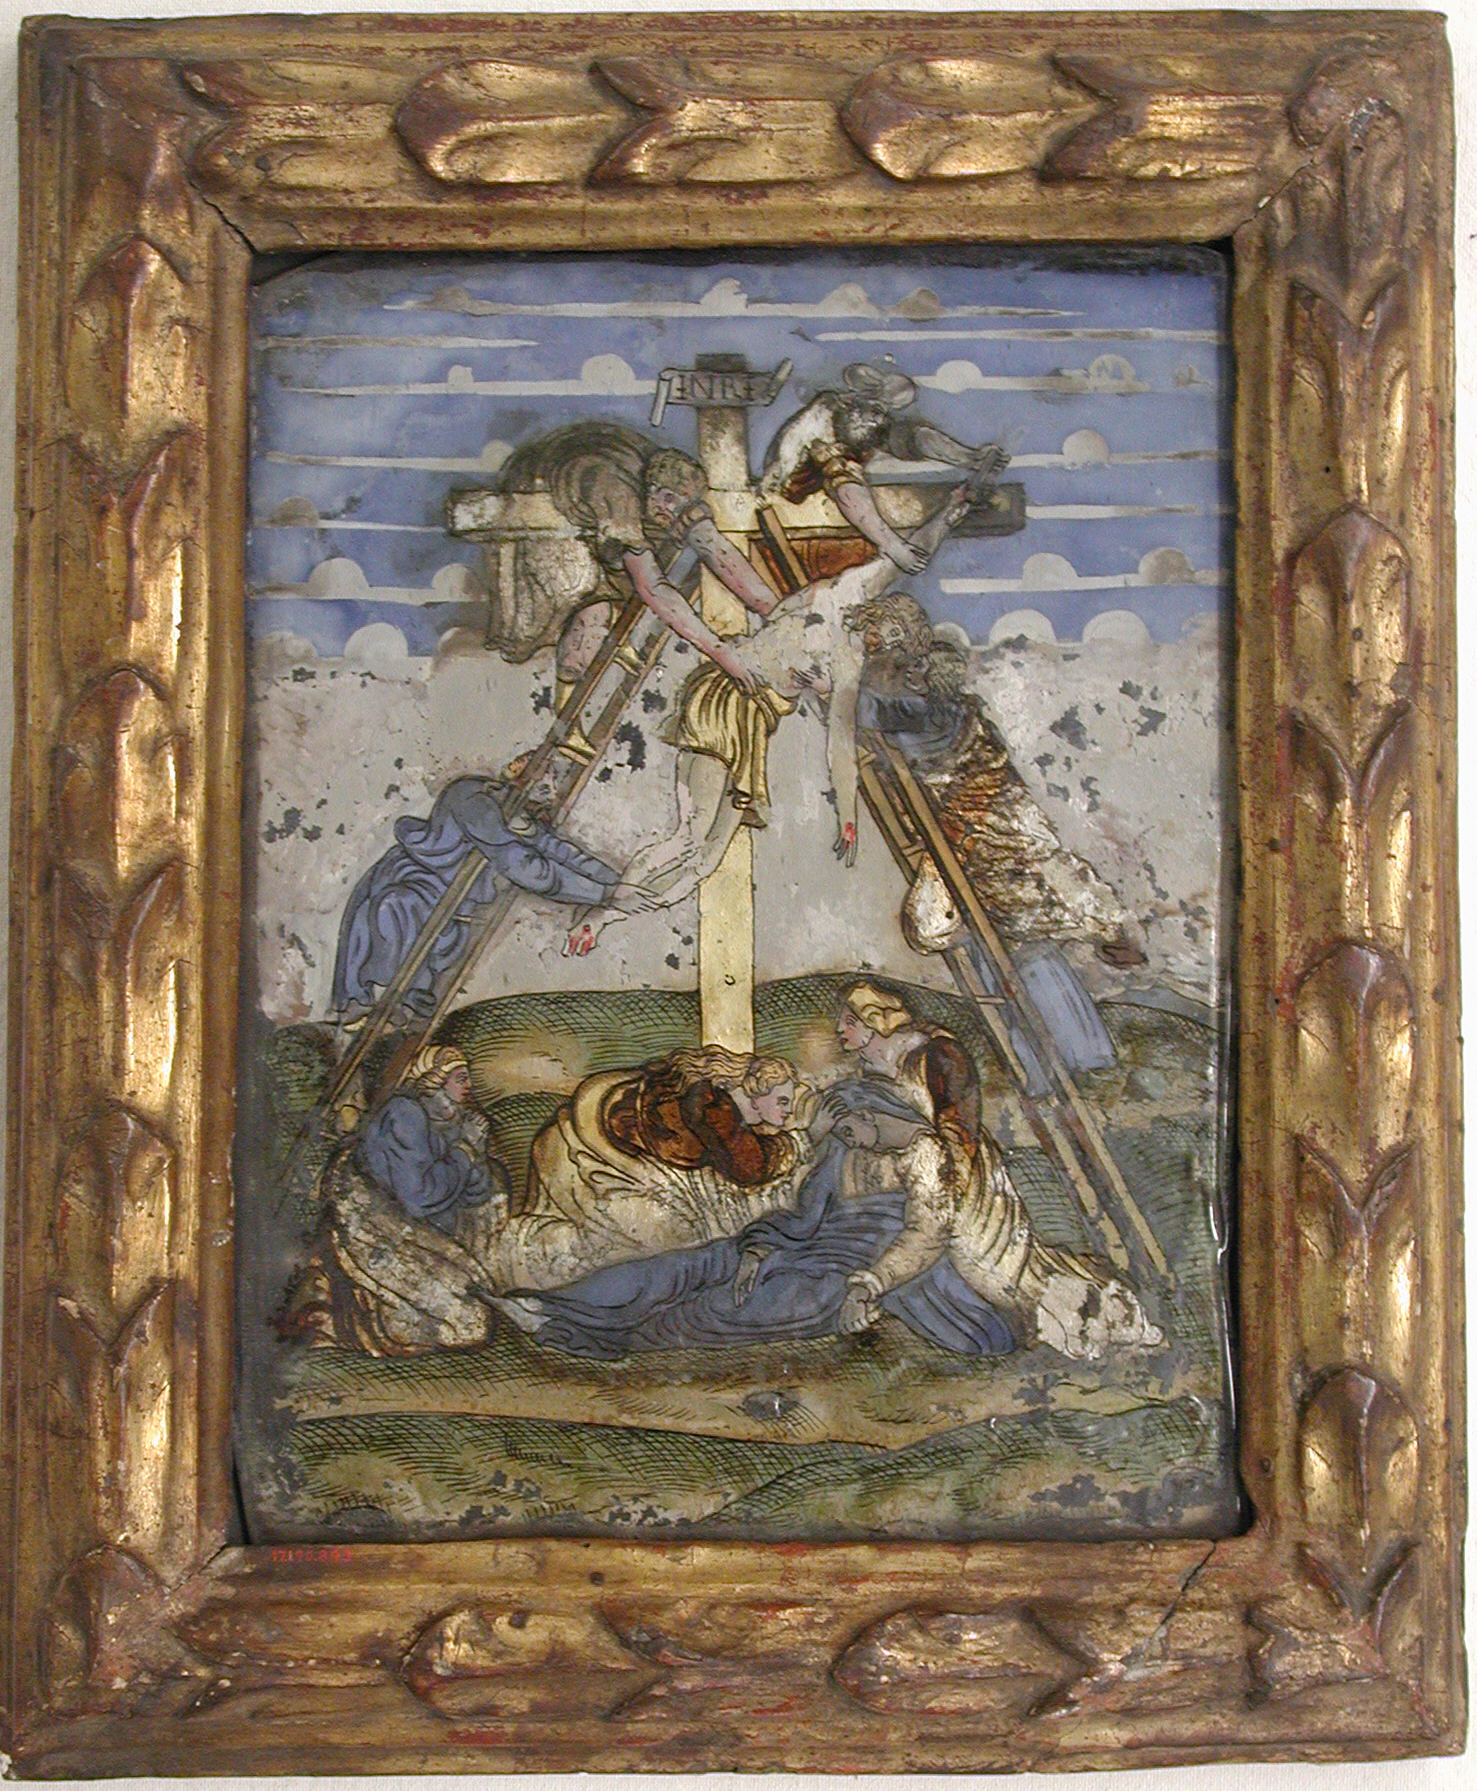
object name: panel or plaque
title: Descent from the Cross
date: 1501-1600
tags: sadness,virgin mary,cross,jesus,descent from the cross